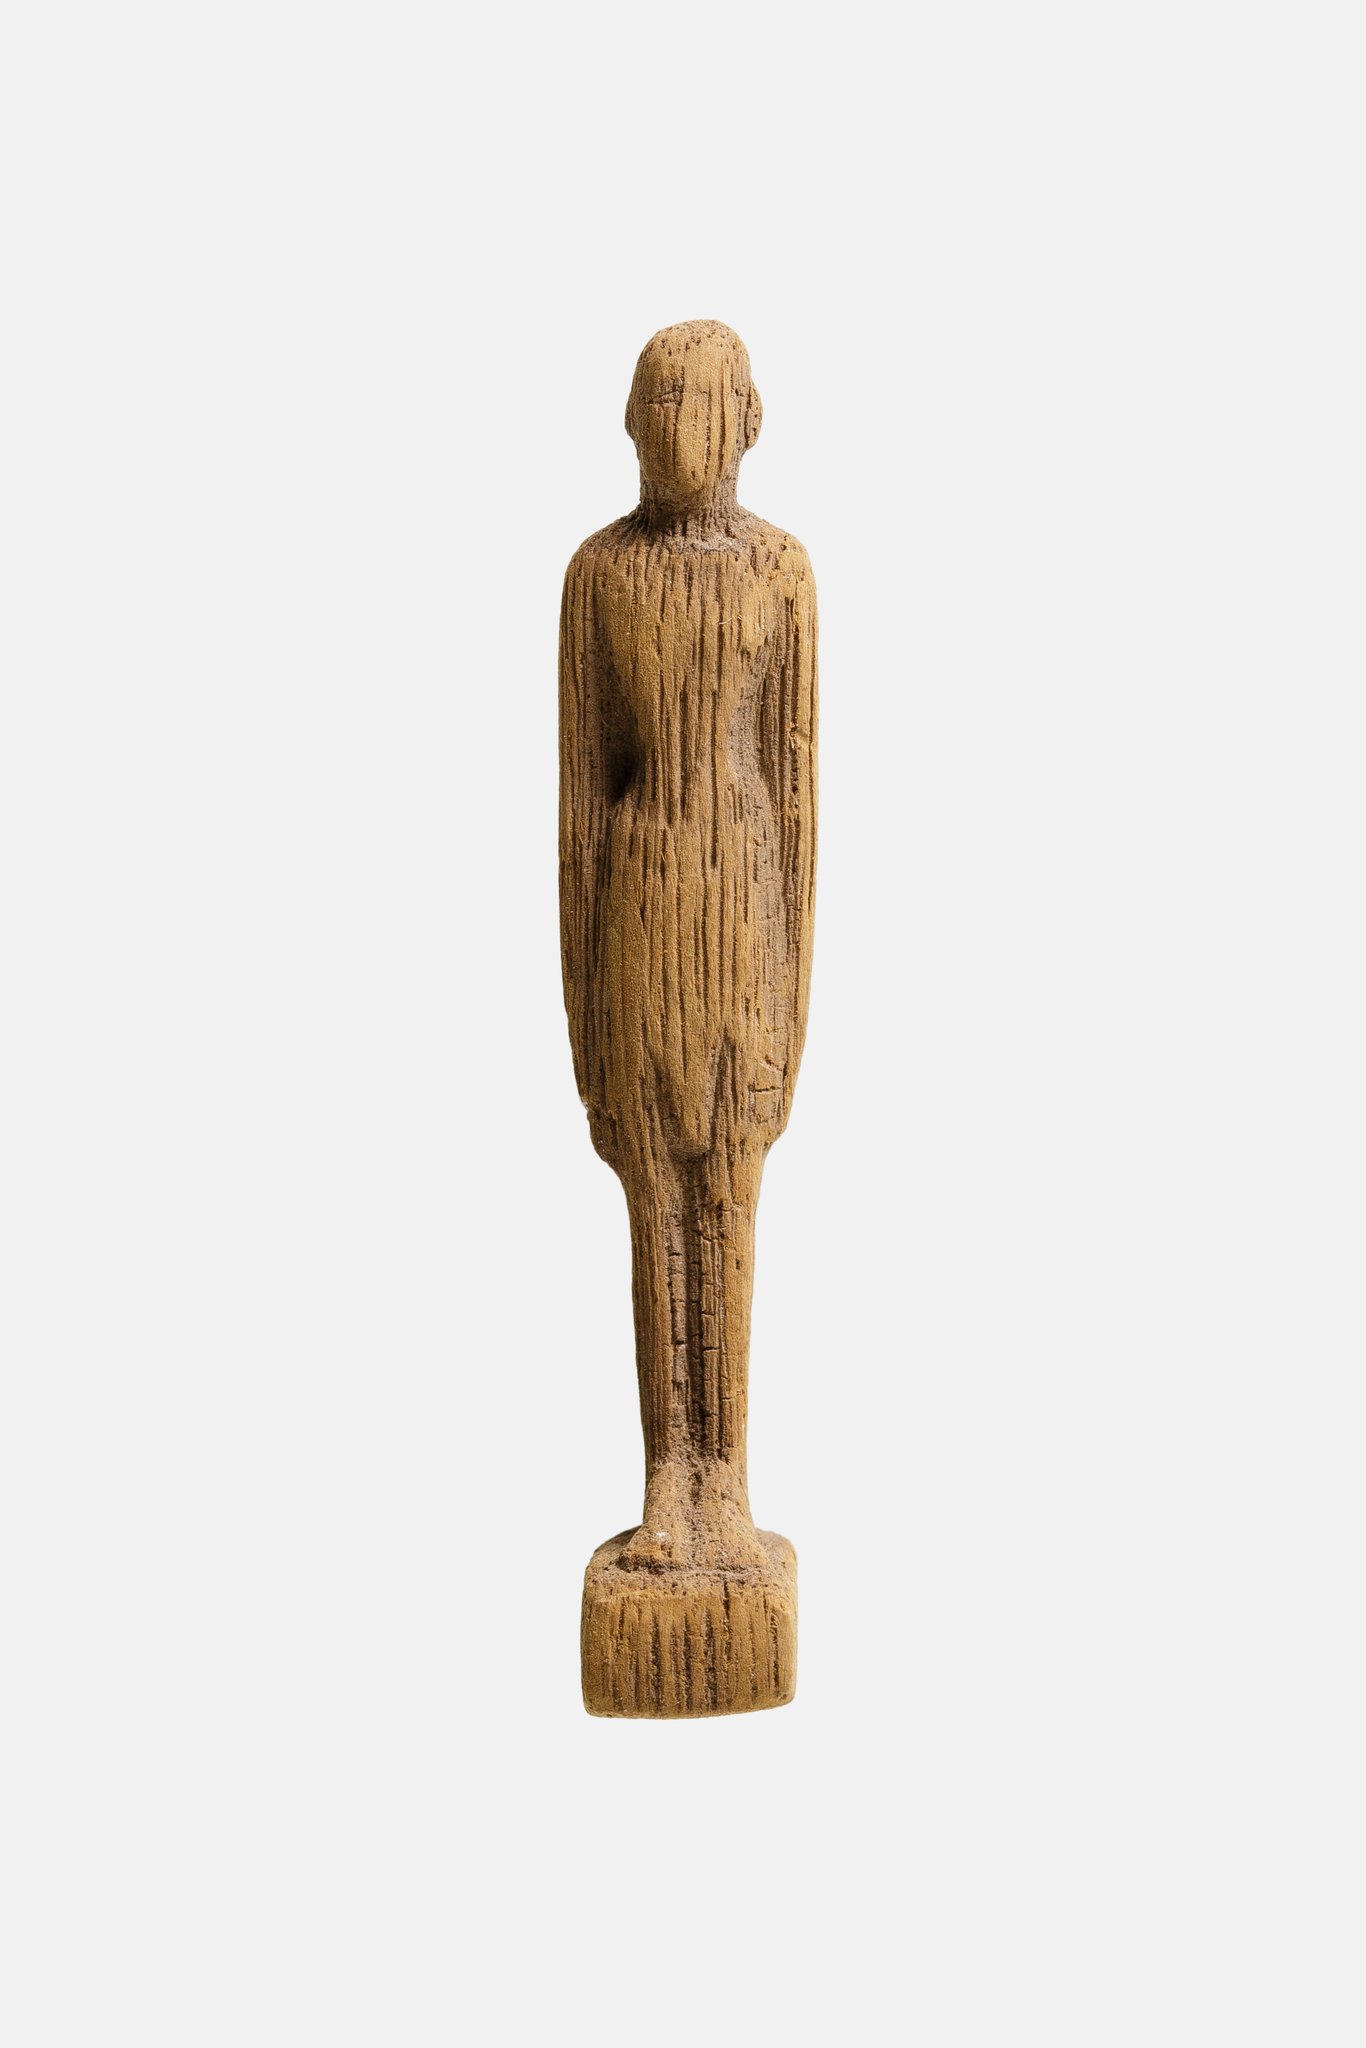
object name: statuette, man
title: Standing man Amulet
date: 1070-343 BCE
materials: wood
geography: egypt